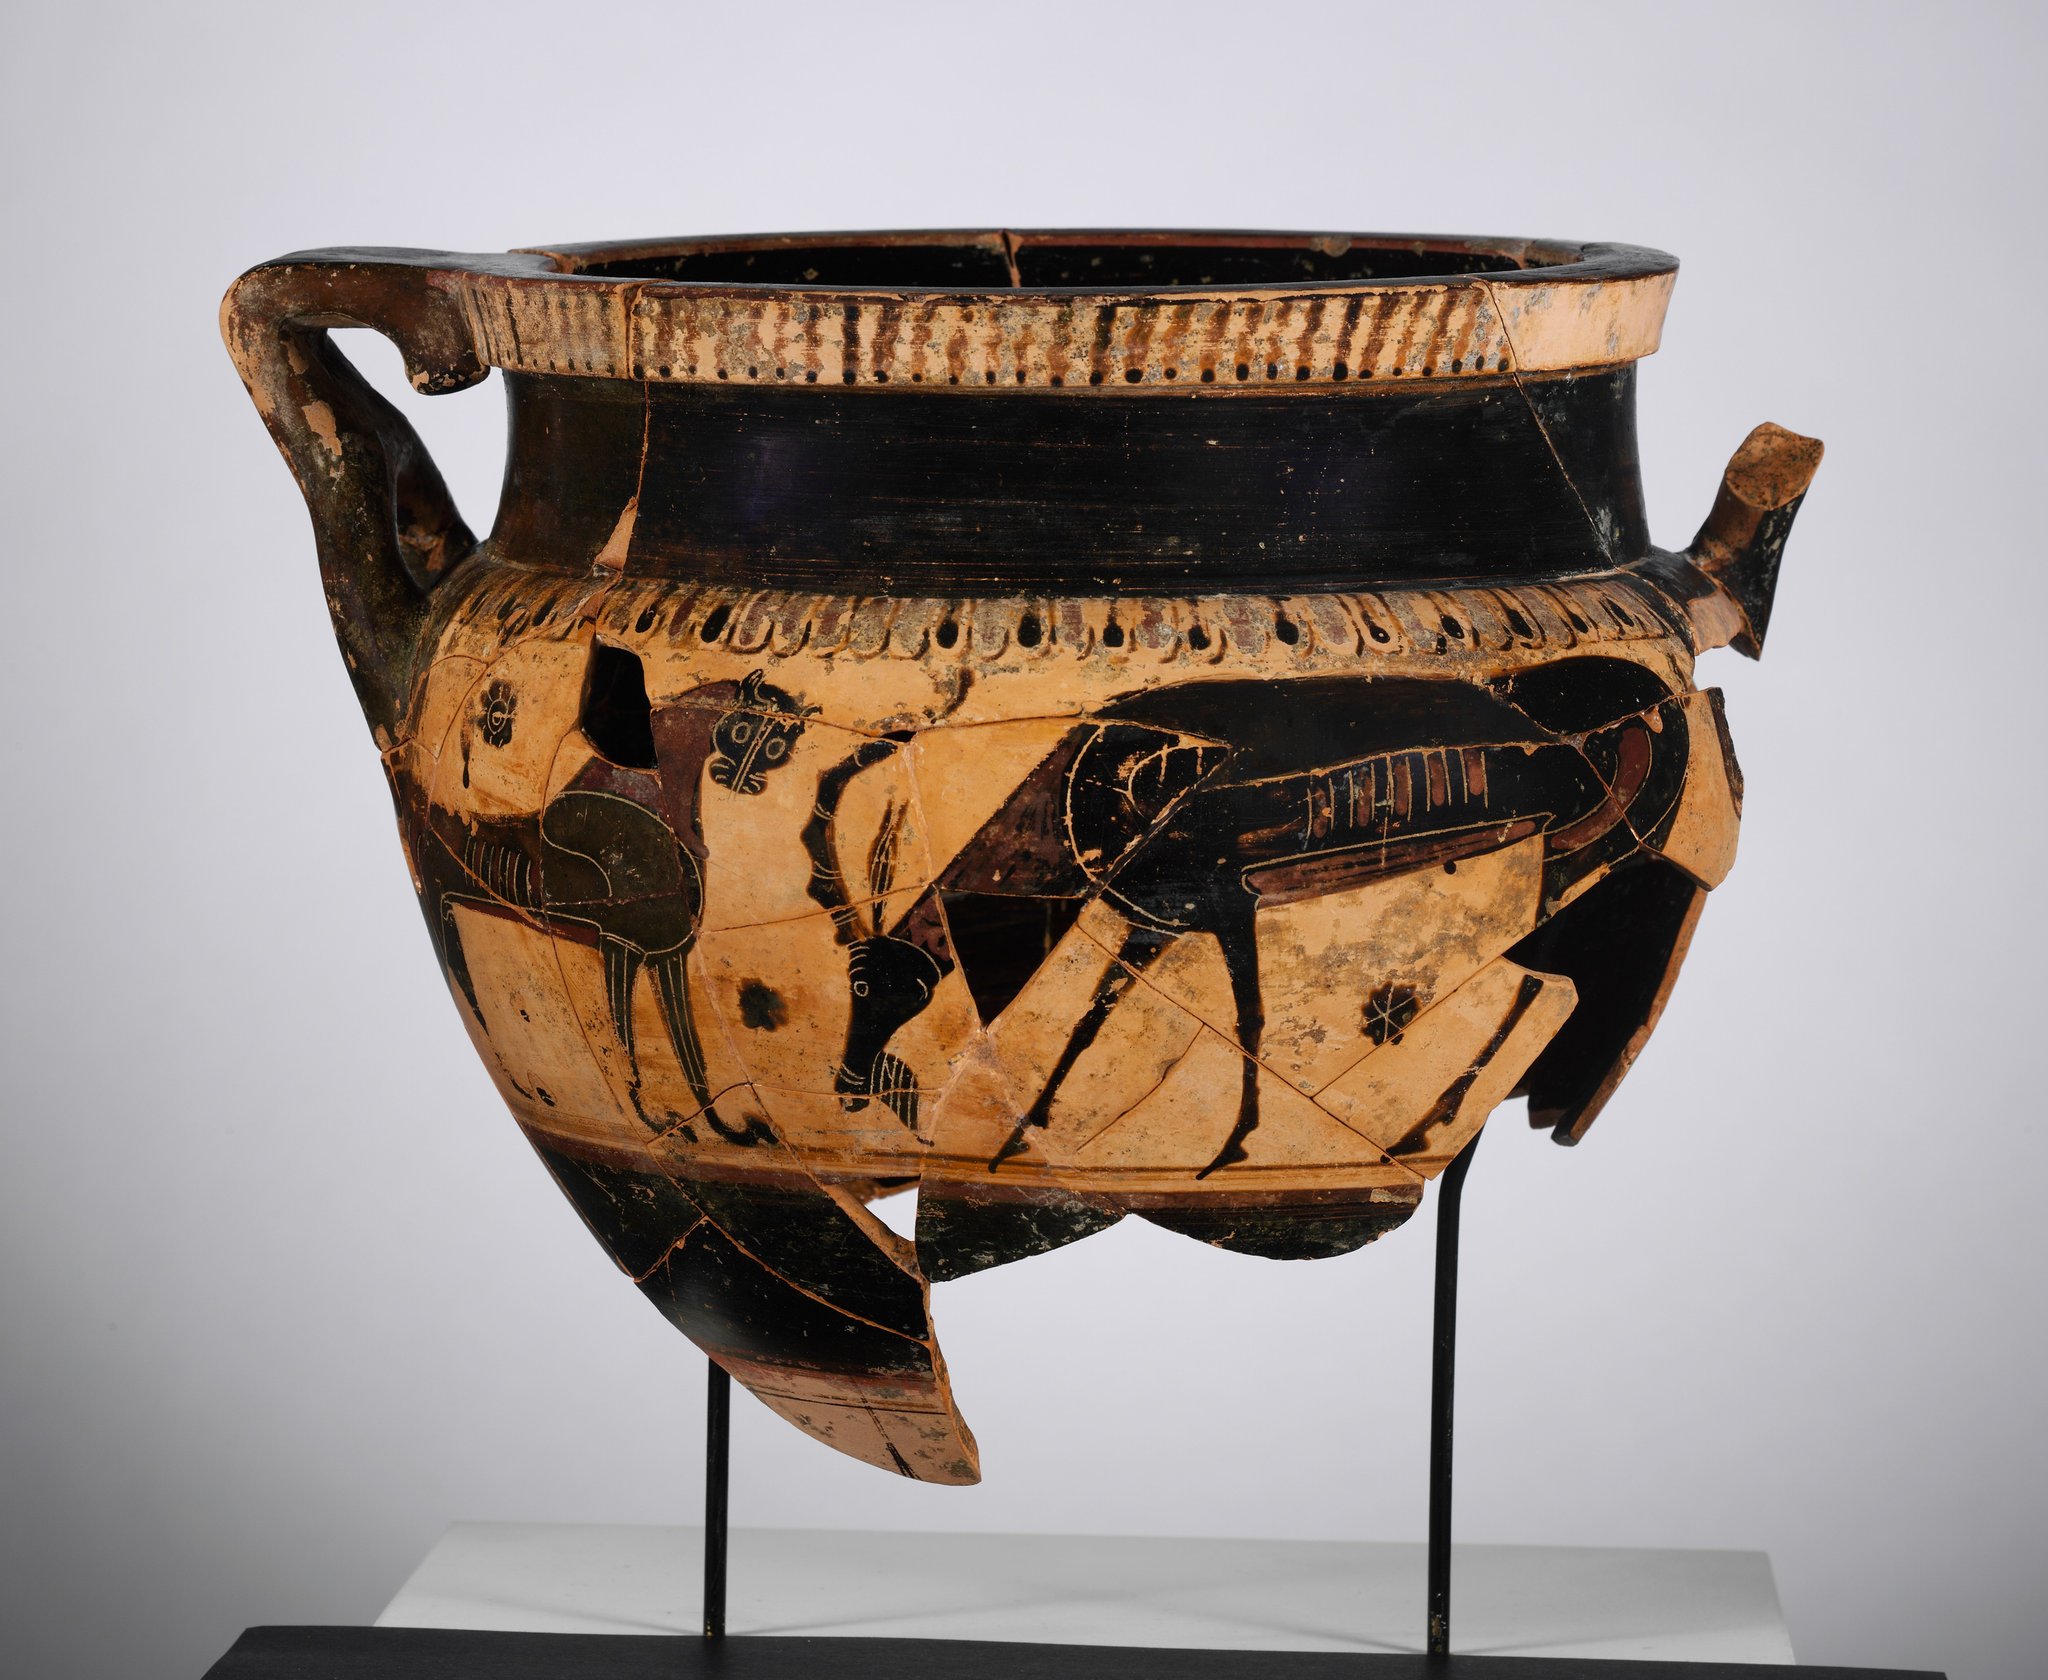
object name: krater chalcidian shape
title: Terracotta krater (bowl for mixing wine and water) of Chalcidian shape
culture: greek, corinthian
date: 580-550 BCE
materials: terracotta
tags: griffins,swans,goats